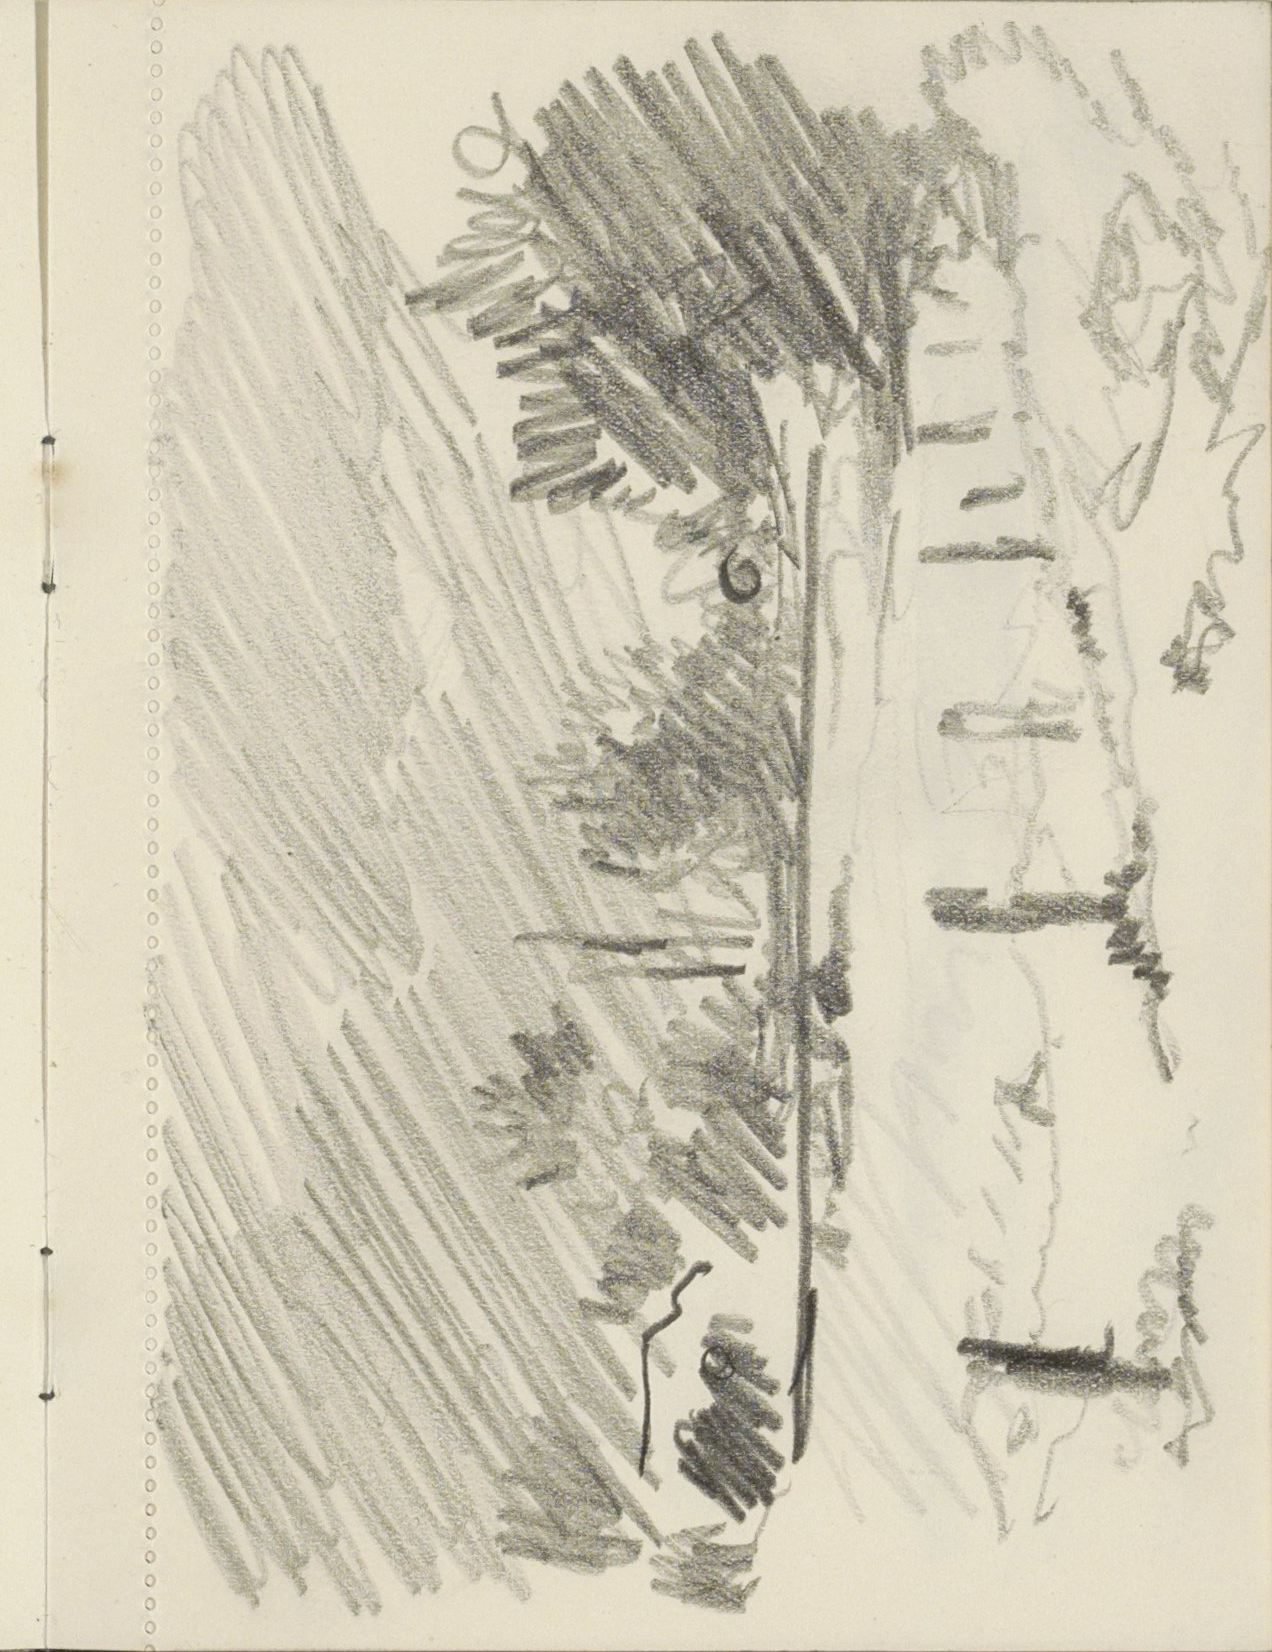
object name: sketchbook leaf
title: Pad in een landschap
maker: cornelis vreedenburgh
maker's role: draughtsman, print maker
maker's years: 1880-1946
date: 1890-1946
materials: paper, pencil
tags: landscapes, road, path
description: Blad 6 recto uit een schetsboek met 71 bladen.